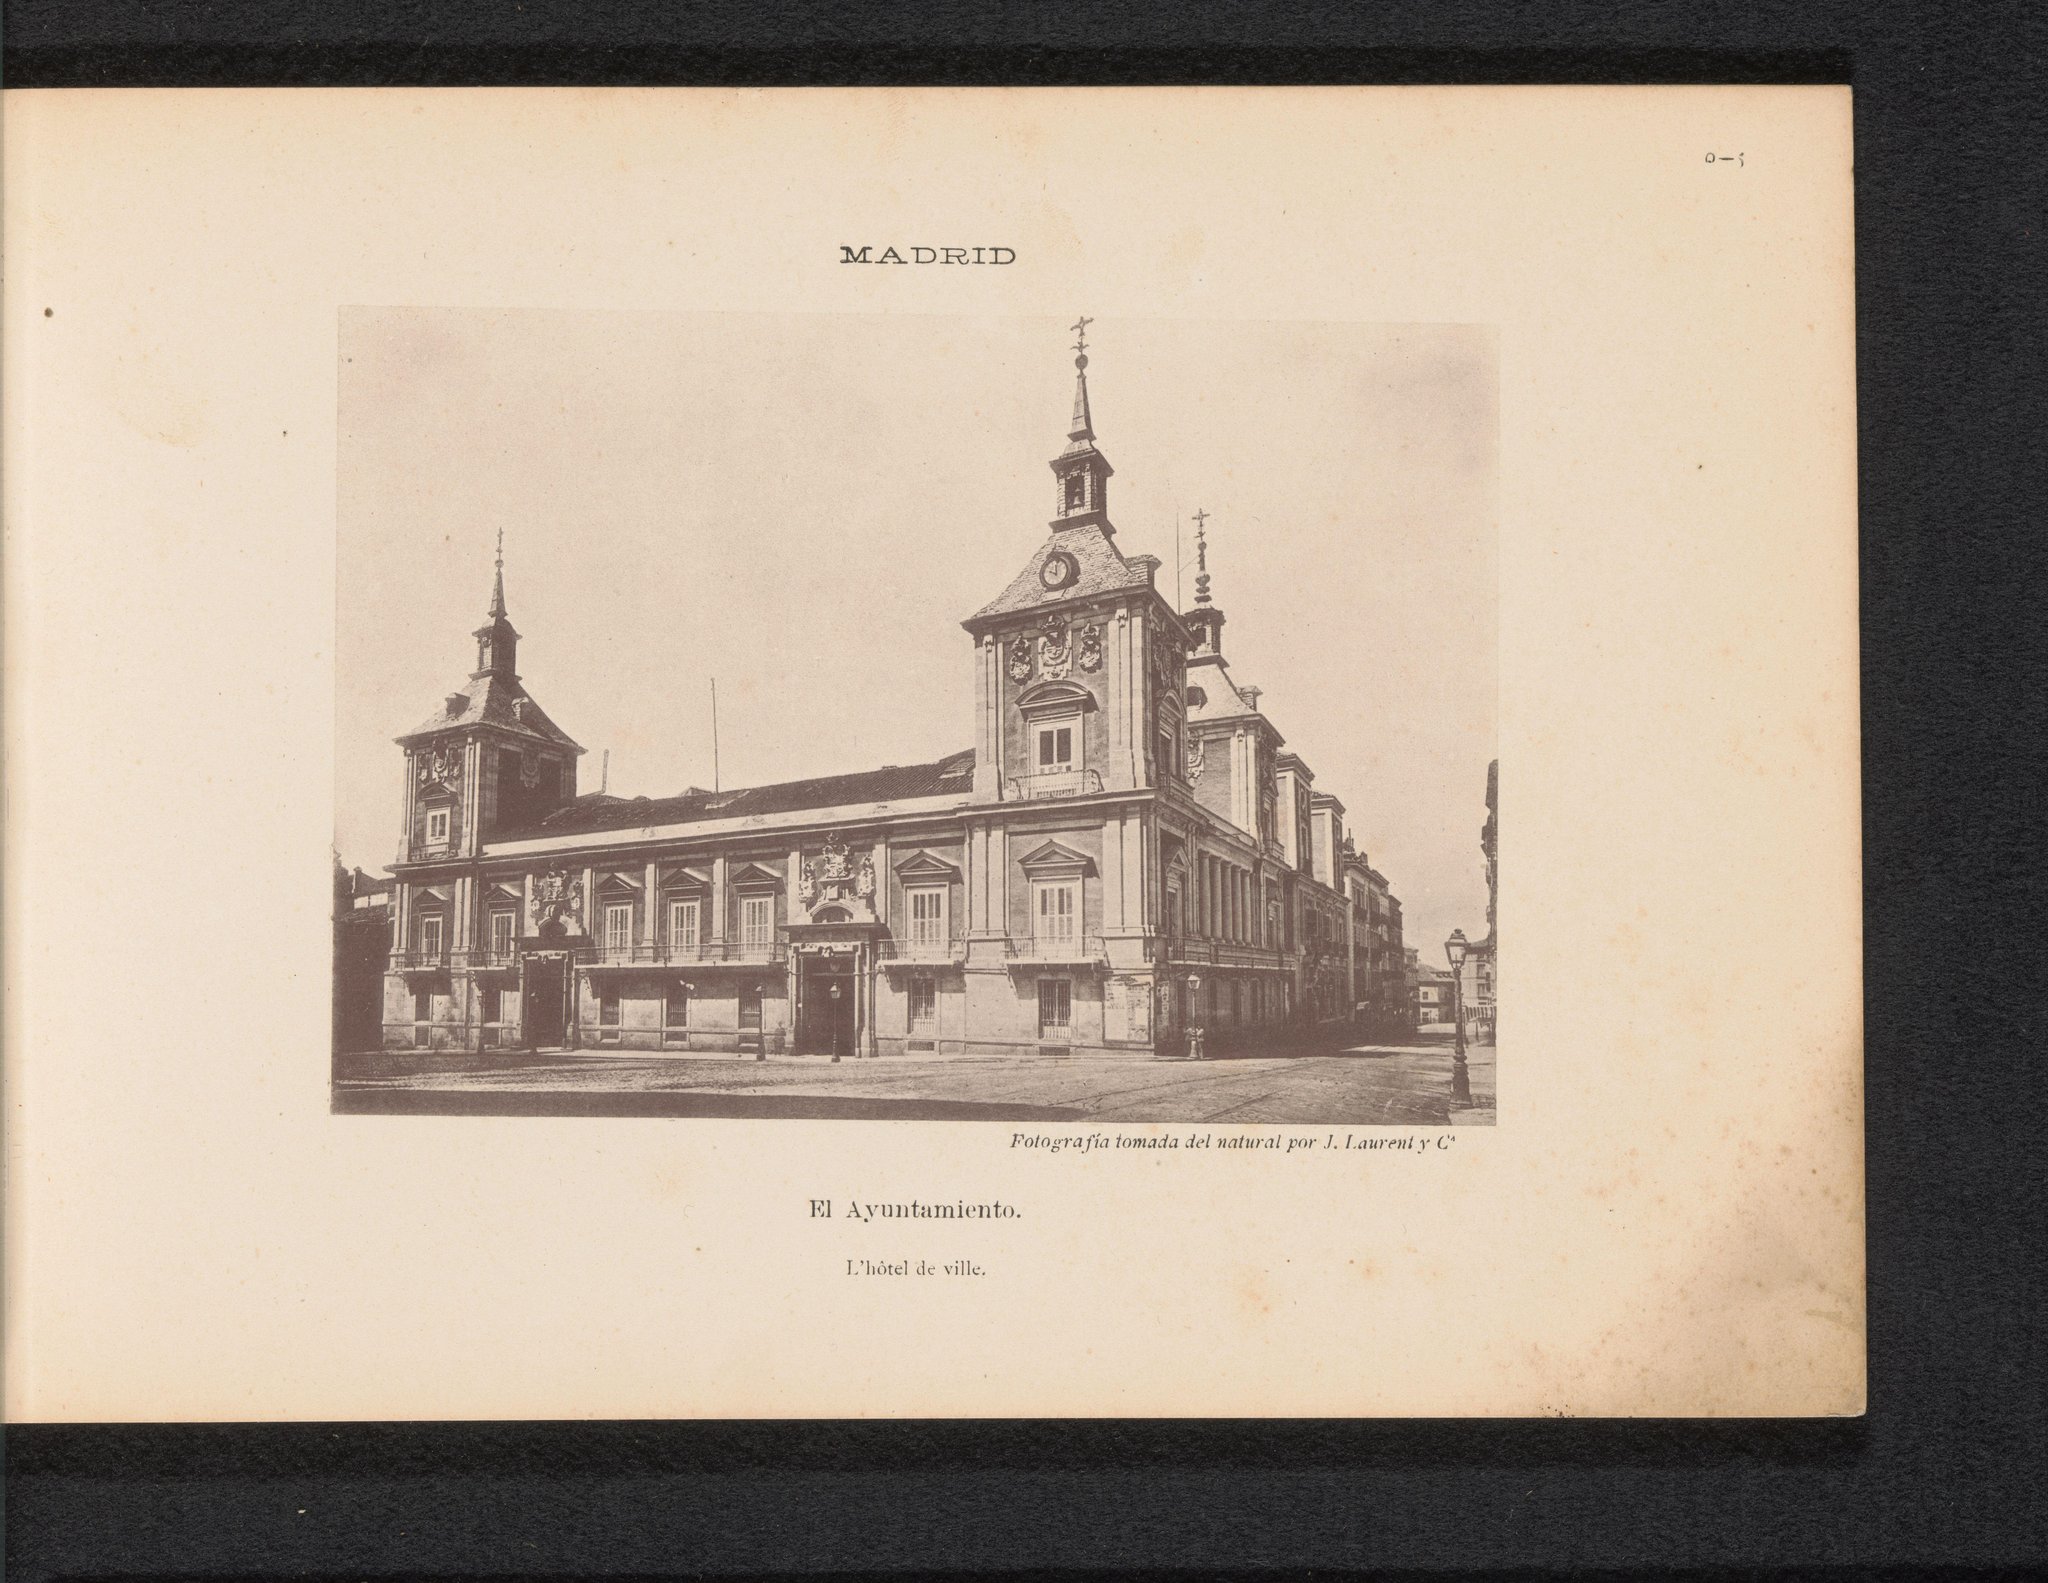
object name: photomechanical print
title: Madrid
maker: juan laurent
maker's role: publisher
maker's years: 1816-1896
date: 1880-1890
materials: paper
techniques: photograph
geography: madrid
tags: townhall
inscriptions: number: ‘0-5’